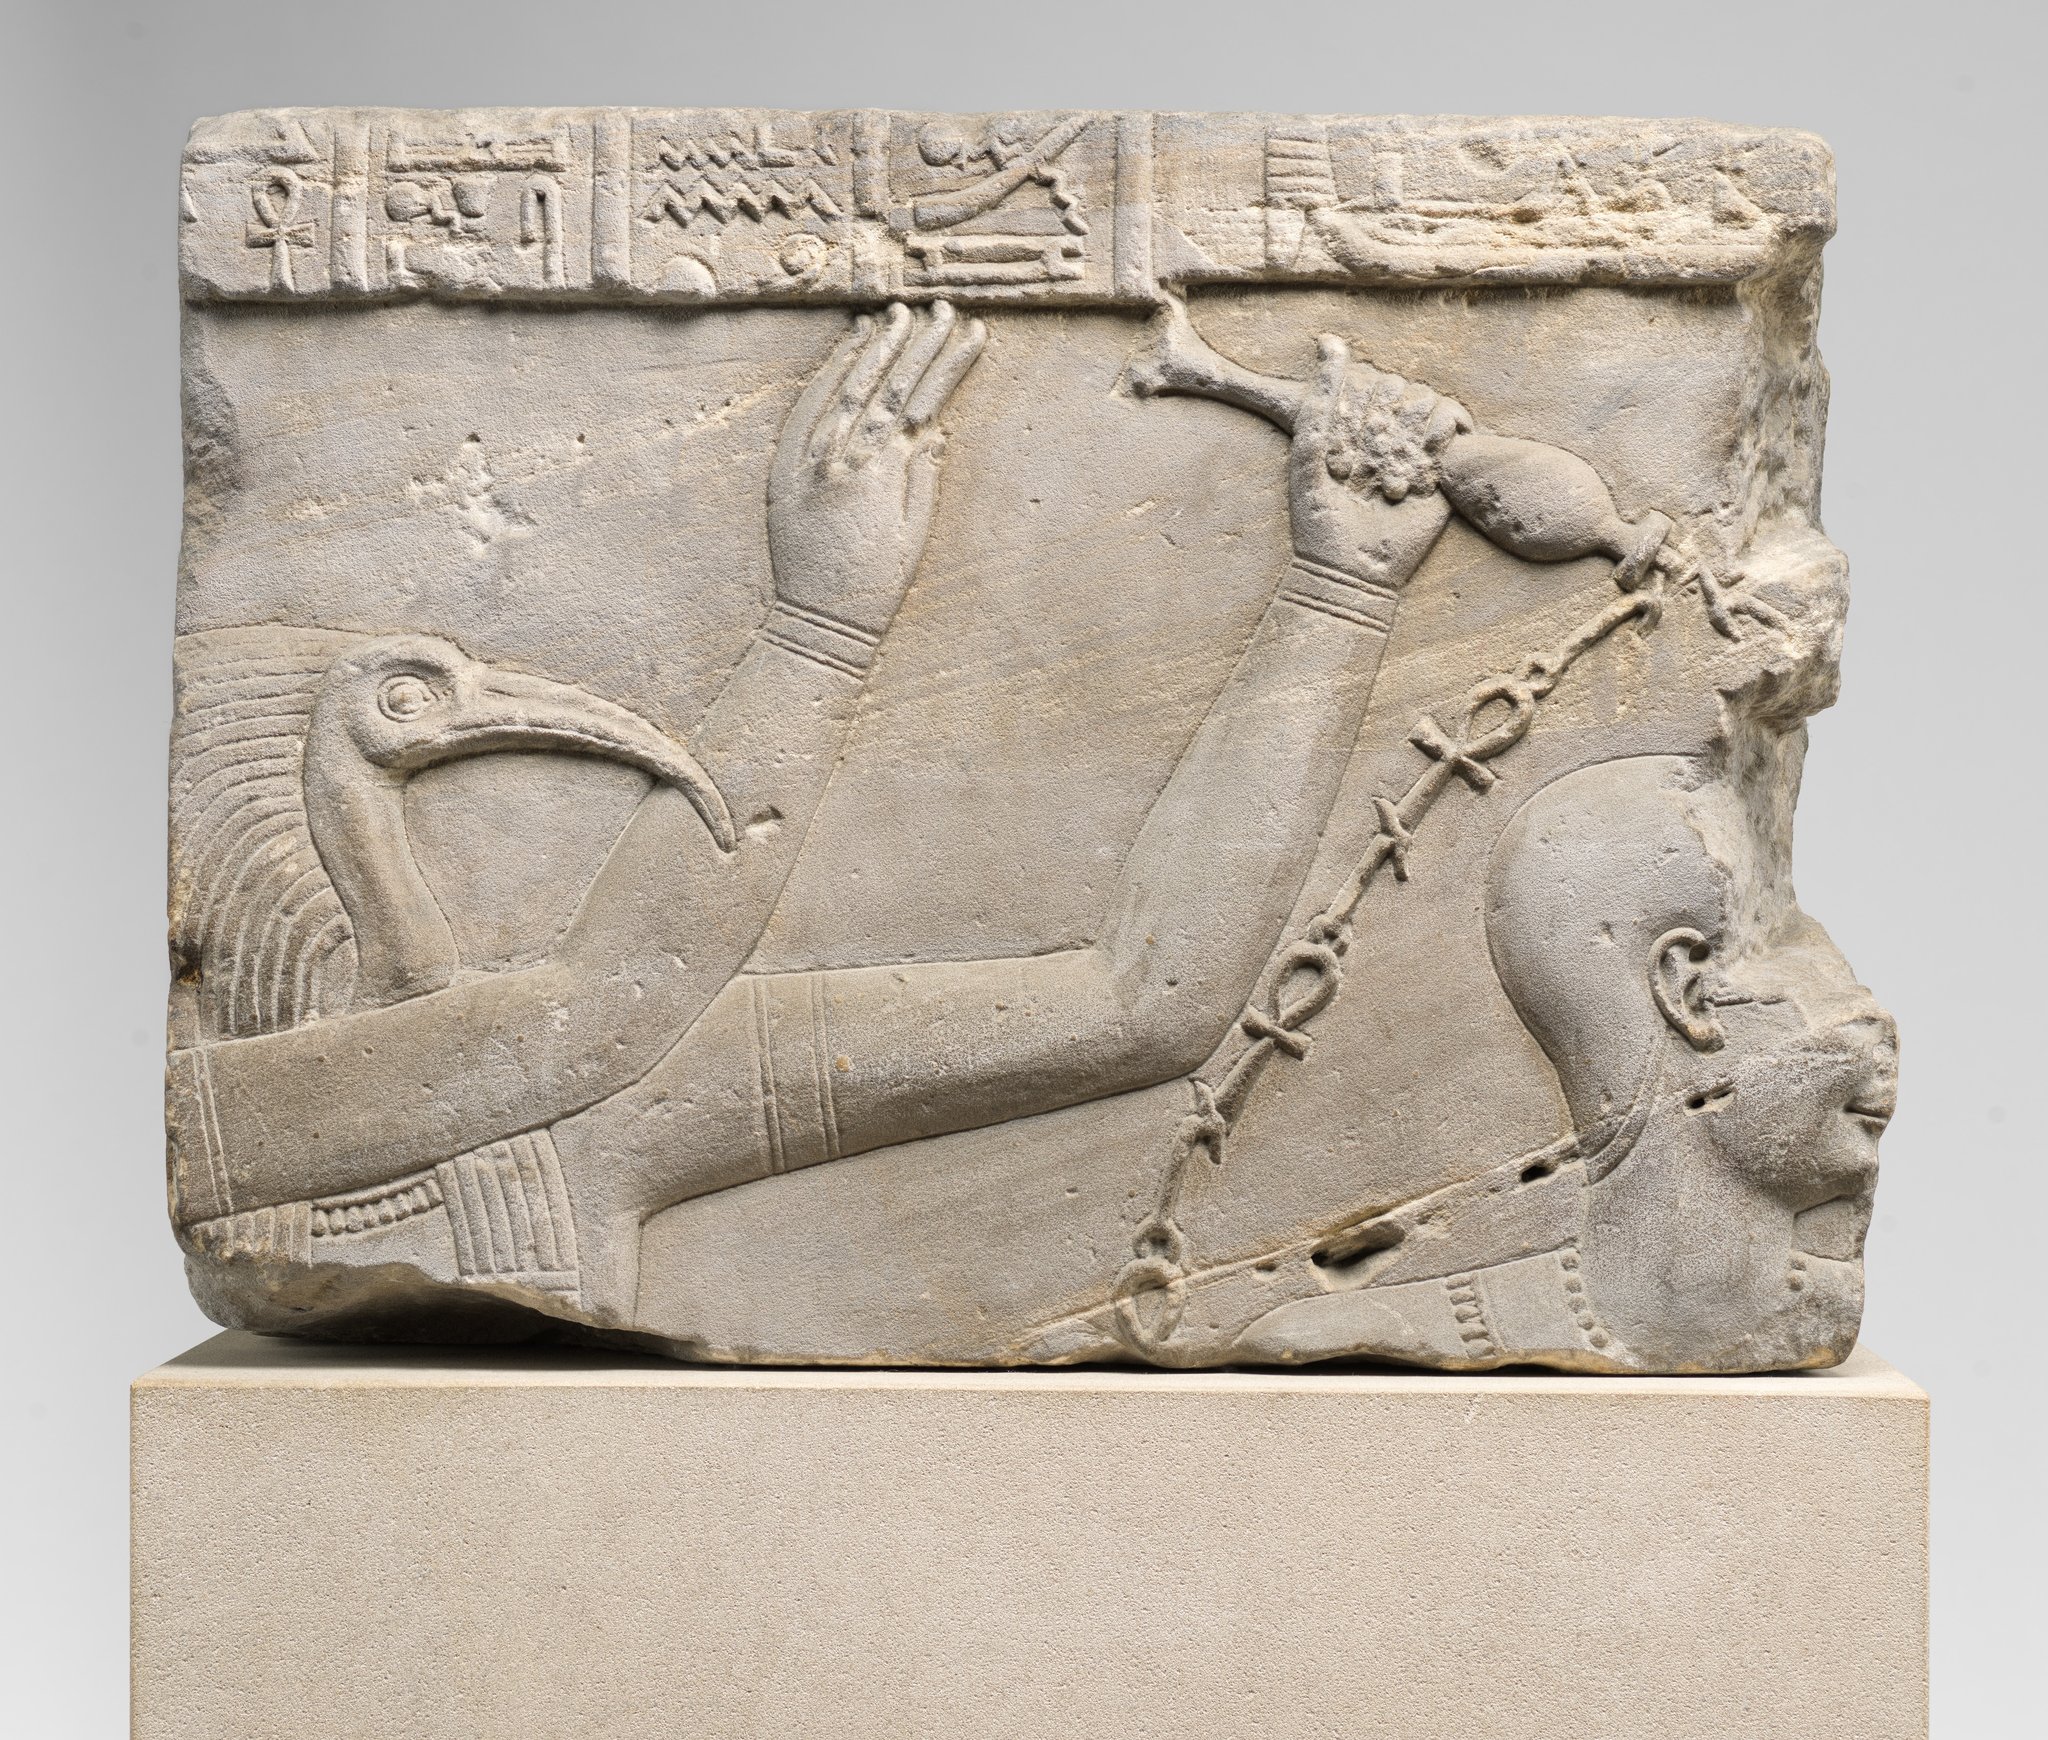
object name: relief, cornice block, baptism of pharaoh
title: Cornice Block with Relief Depicting the Purification of the Pharaoh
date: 41-68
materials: stone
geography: egypt